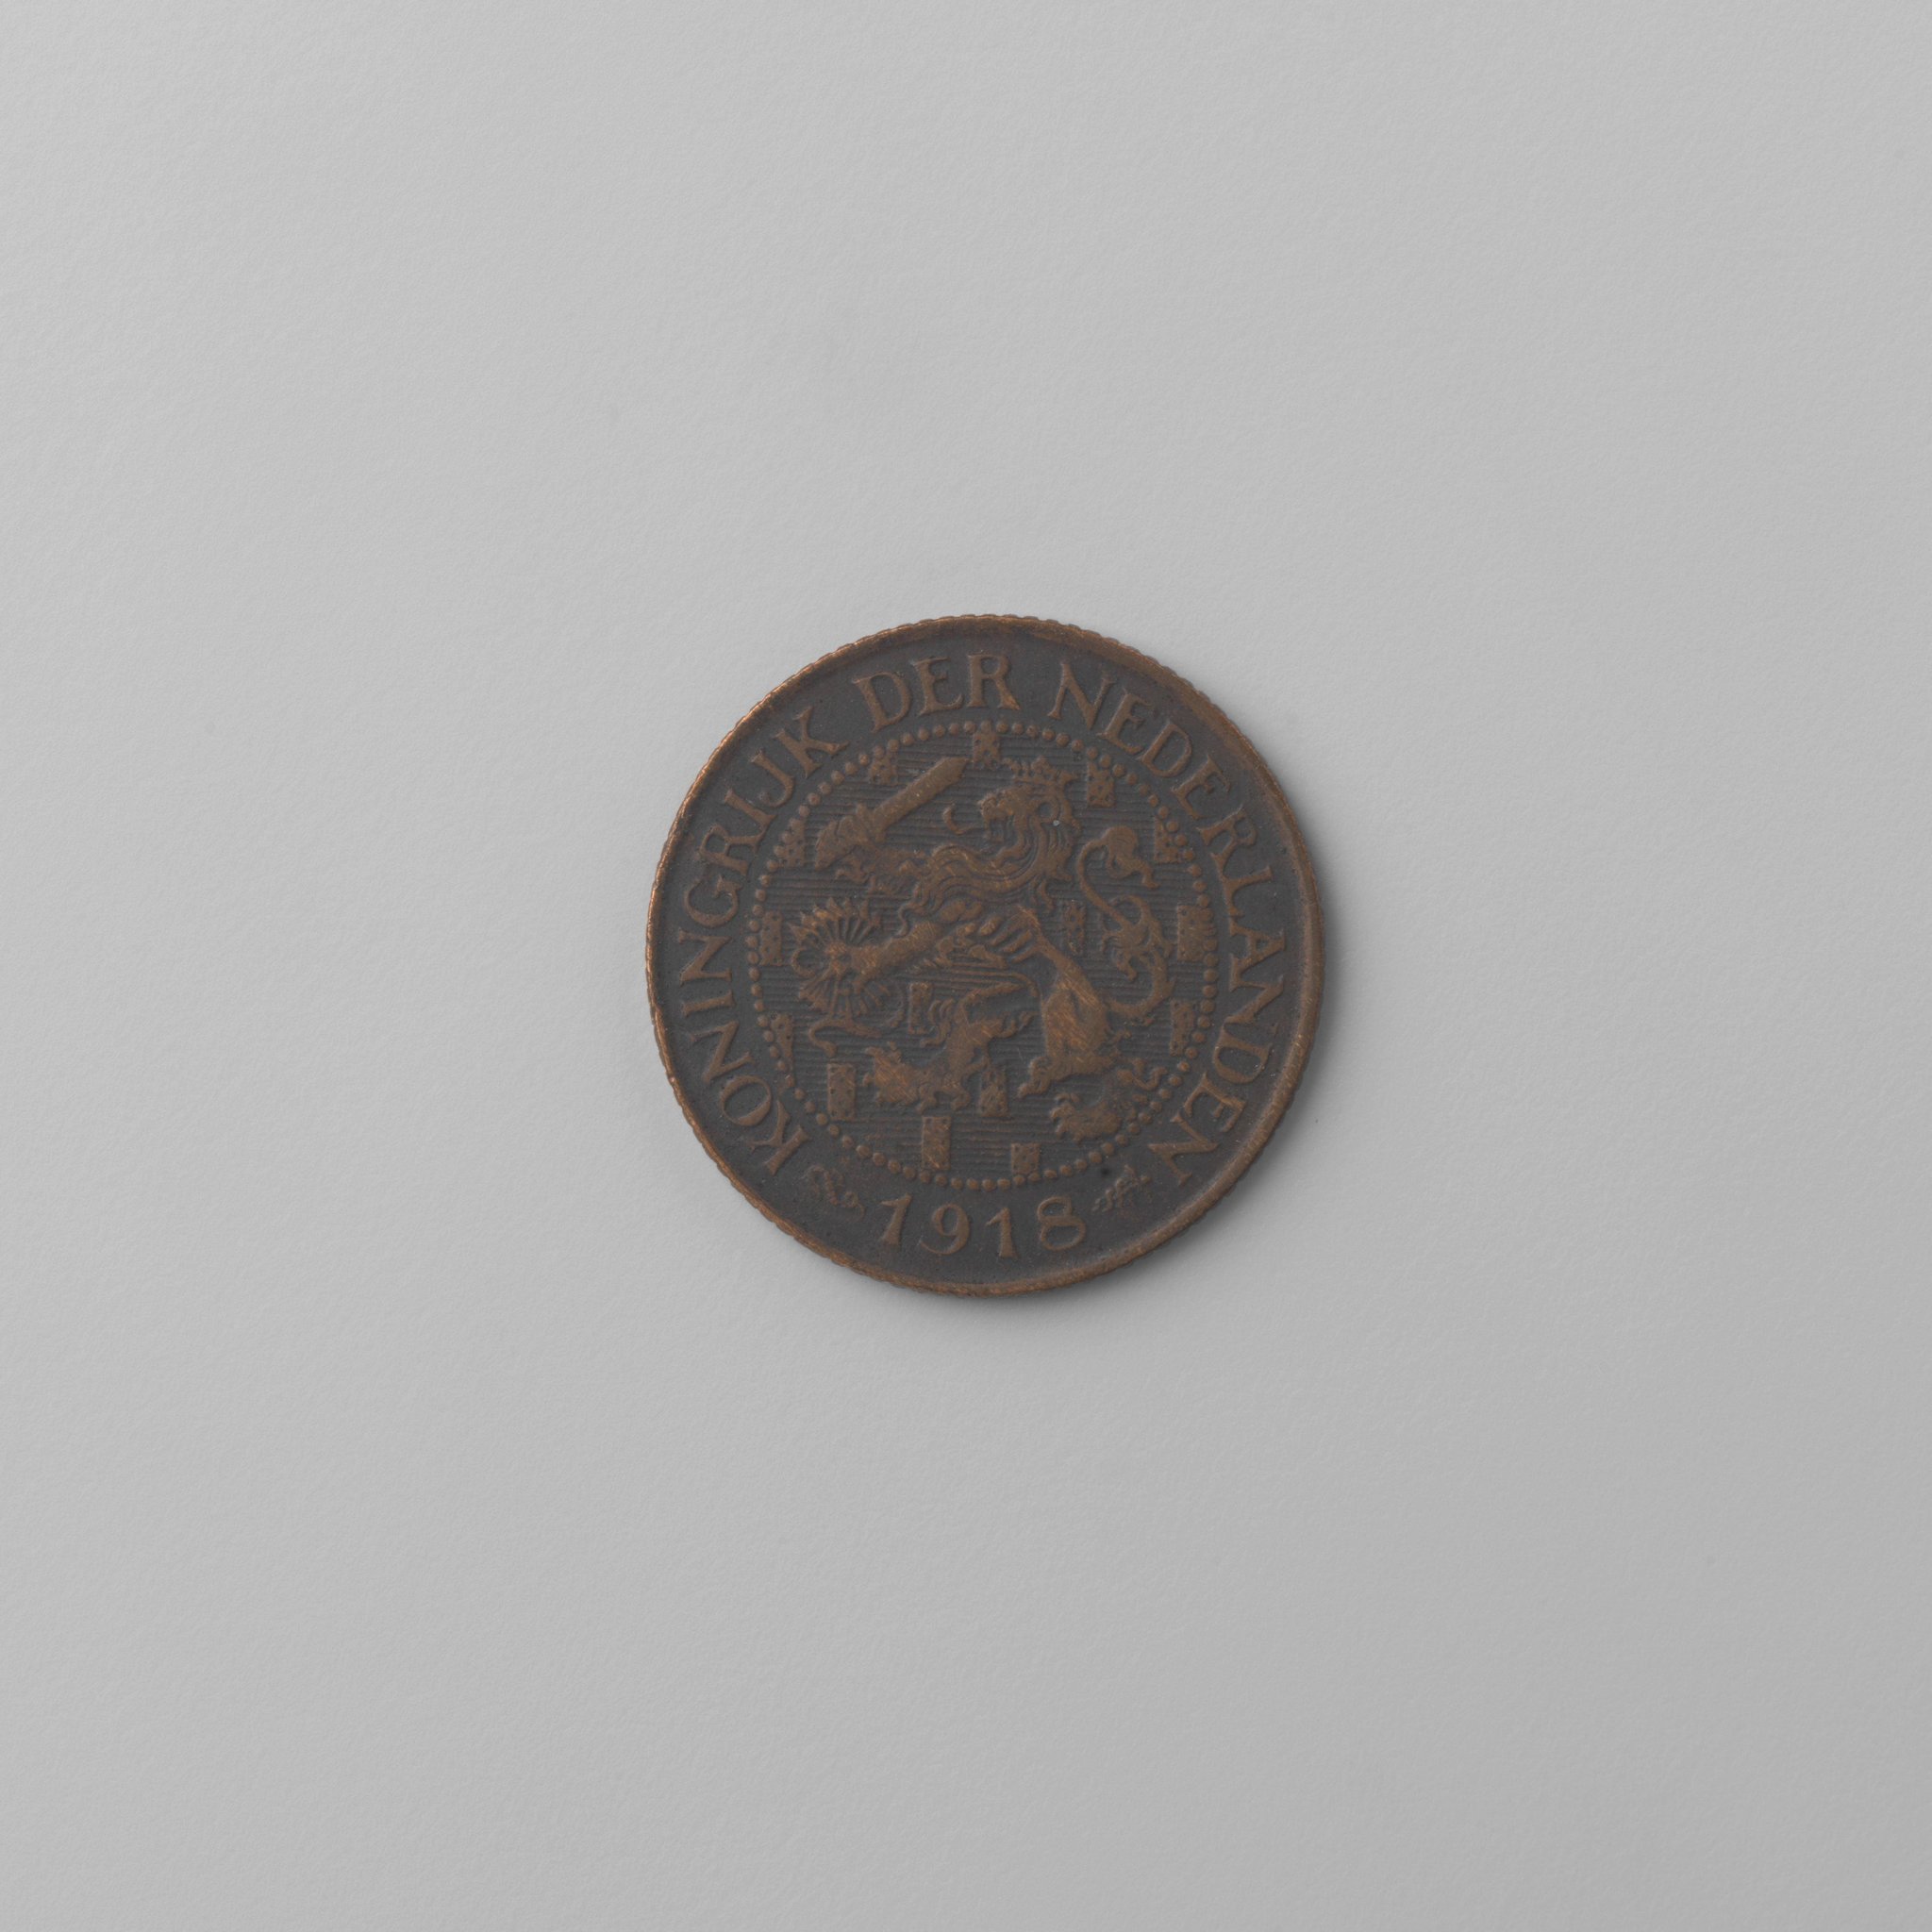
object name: cent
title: Nederland, cent,1918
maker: wilhelmina of the netherlands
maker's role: print maker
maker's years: 1880-1962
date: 1918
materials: bronze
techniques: striking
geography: utrecht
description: Bronzen munt. Voorzijde: in een veld rijkswapen. Jaartal onderaan in omschrift. Keerzijde: binnen twee samengebonden oranjetakken waarde-aanduiding 1 cent. Kartelrand.